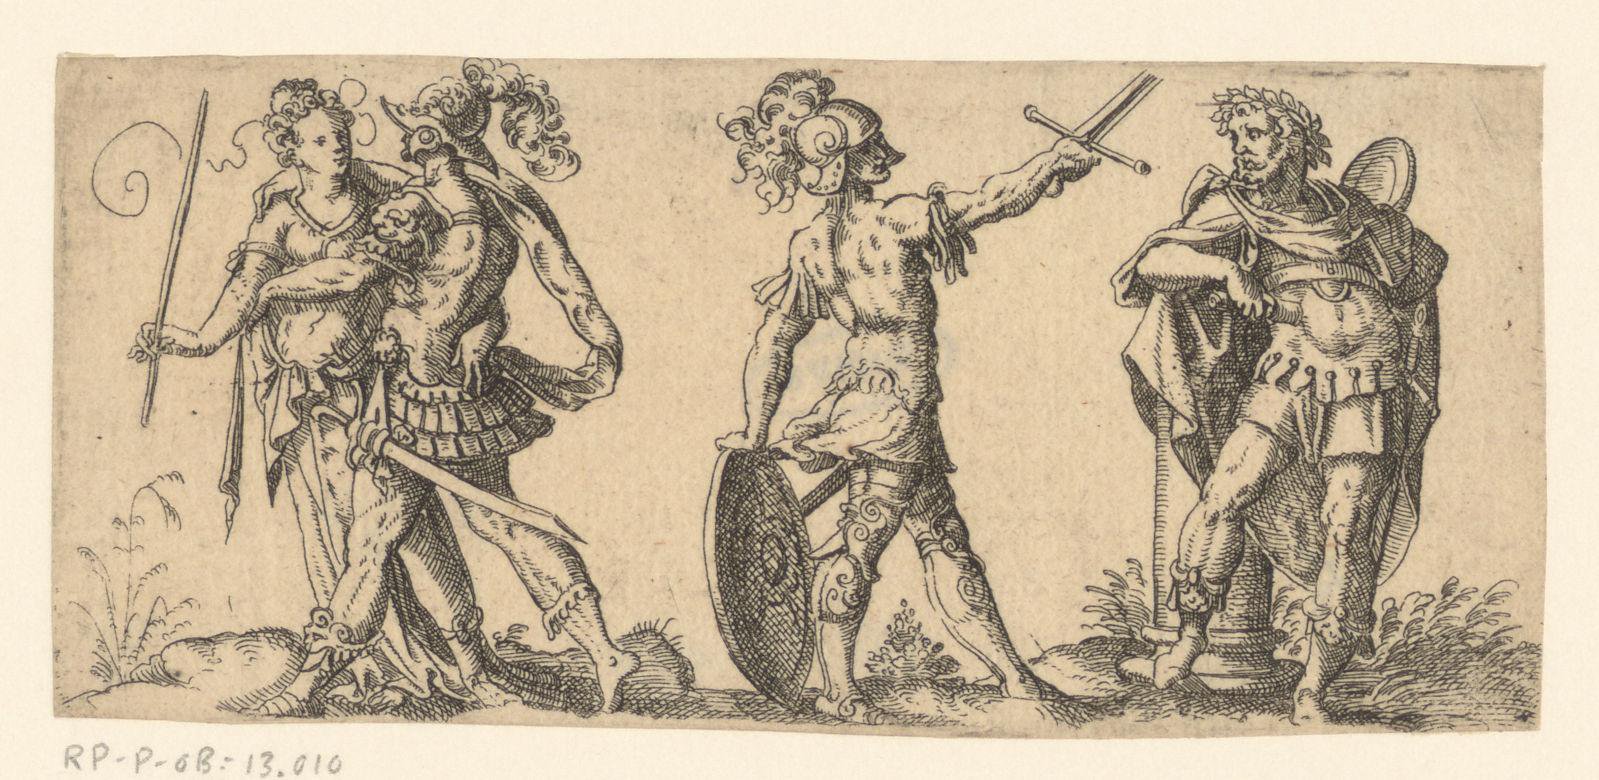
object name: print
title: Drie krijgers, een van hen omhelst een vrouw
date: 1590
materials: paper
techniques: etching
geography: nuremberg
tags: armour, the soldier; the soldier's life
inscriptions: collector's mark: Lugt 2228